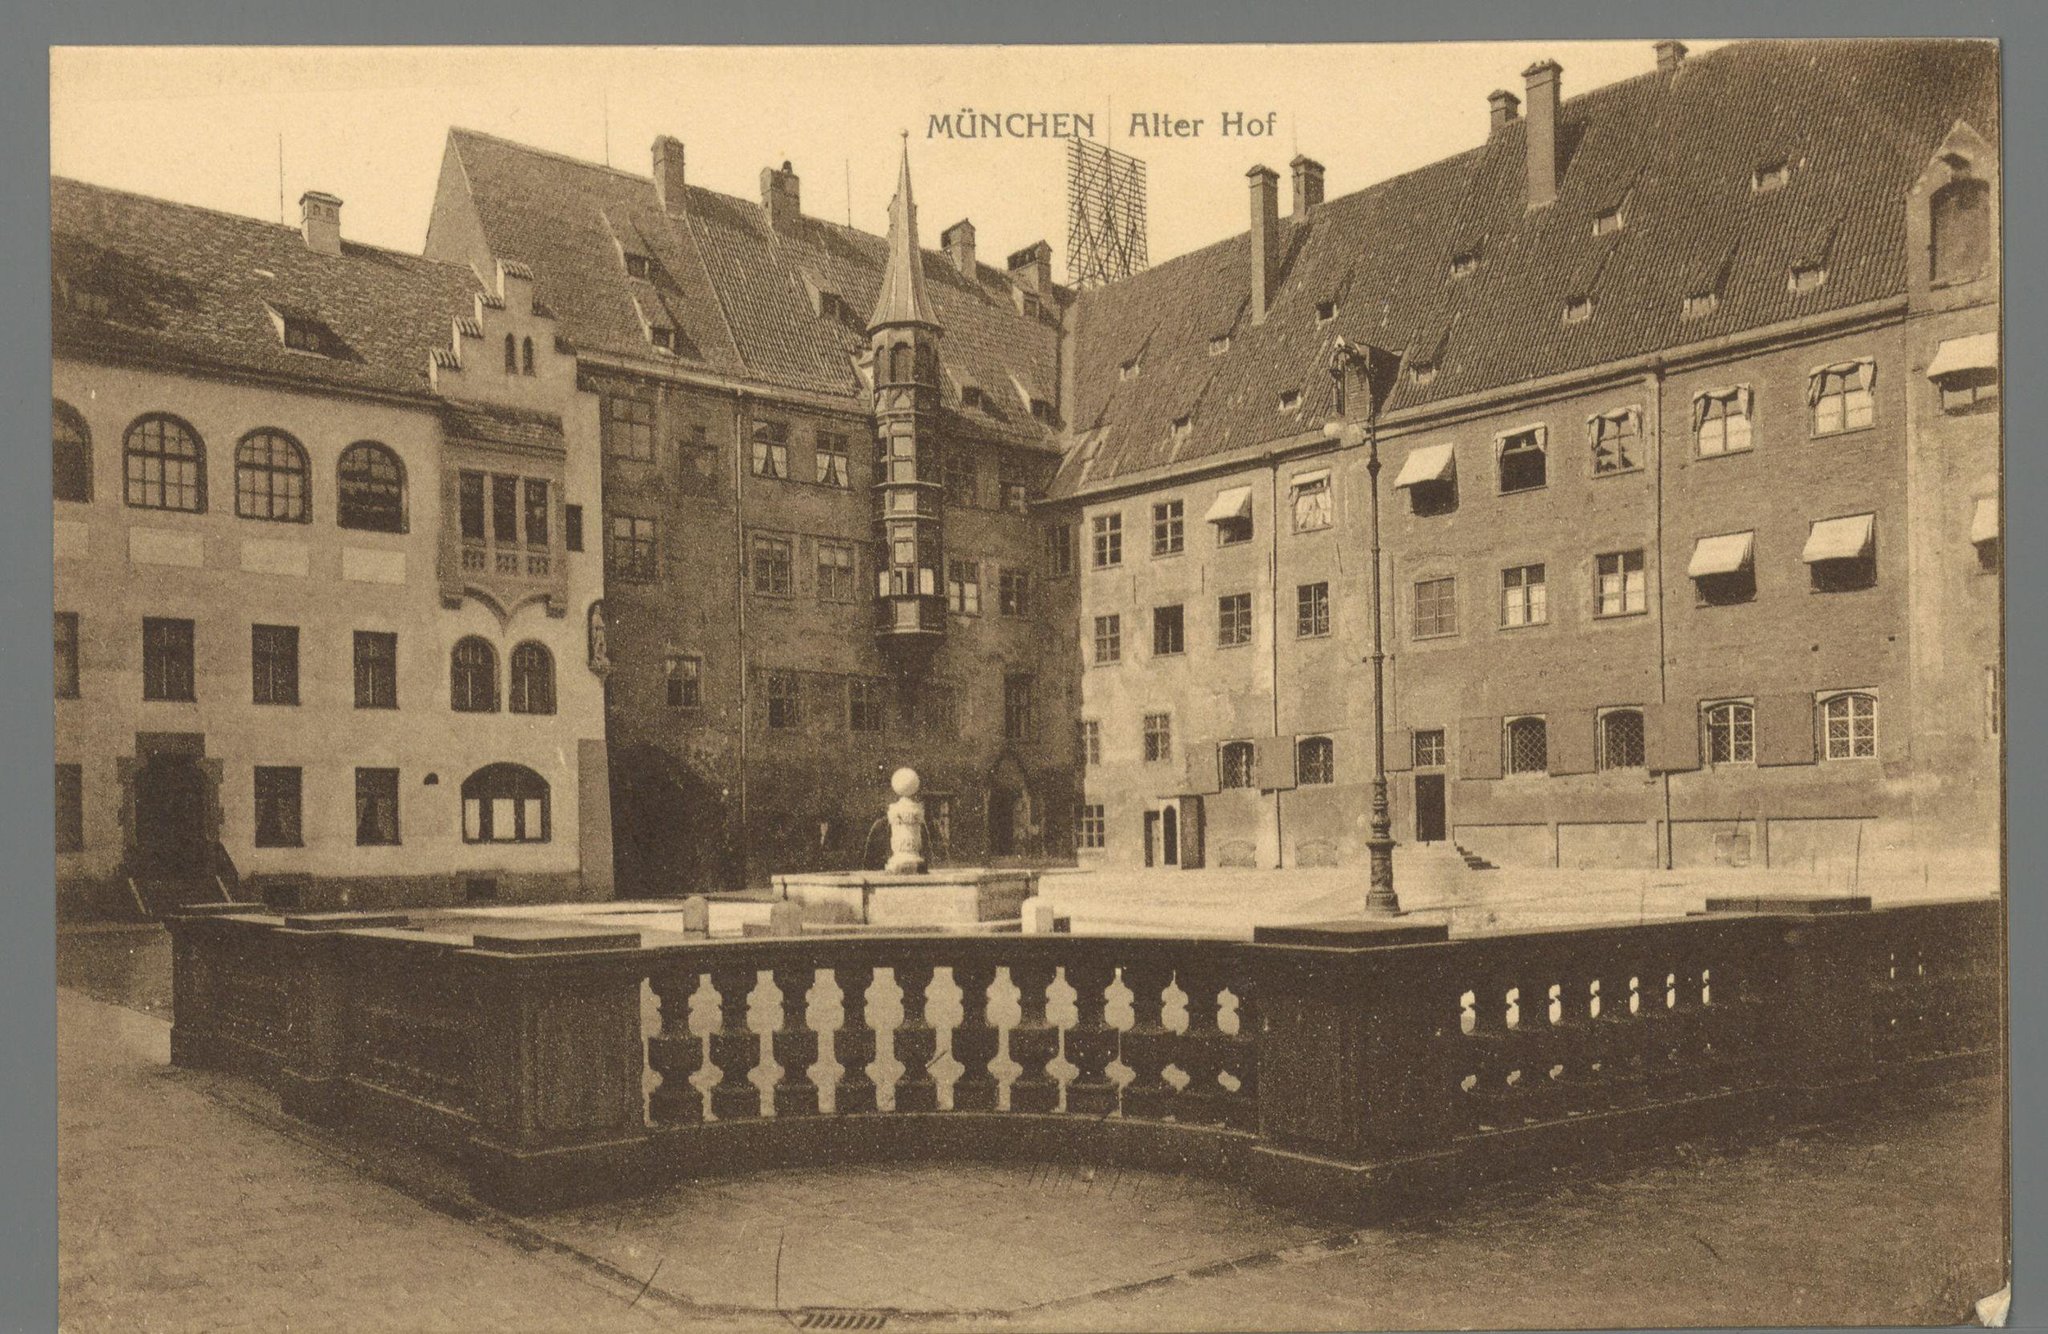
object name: photomechanical print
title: München. Alter Hof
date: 1905-1909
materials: cardboard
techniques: photograph, writing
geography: munich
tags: palace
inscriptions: inscription: ‘W.H.D.’